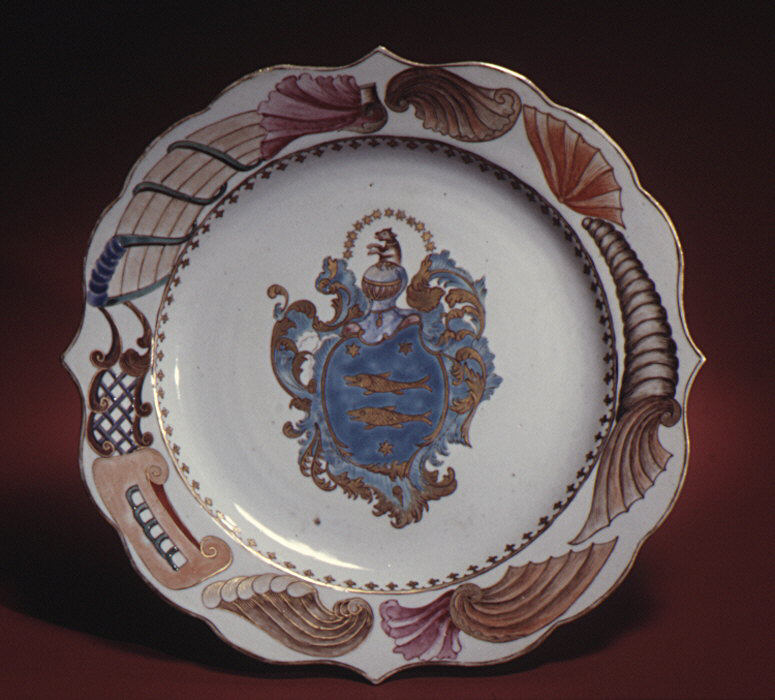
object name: dinner plate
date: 1740-1745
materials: hard paste porcelain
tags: fish,coat of arms